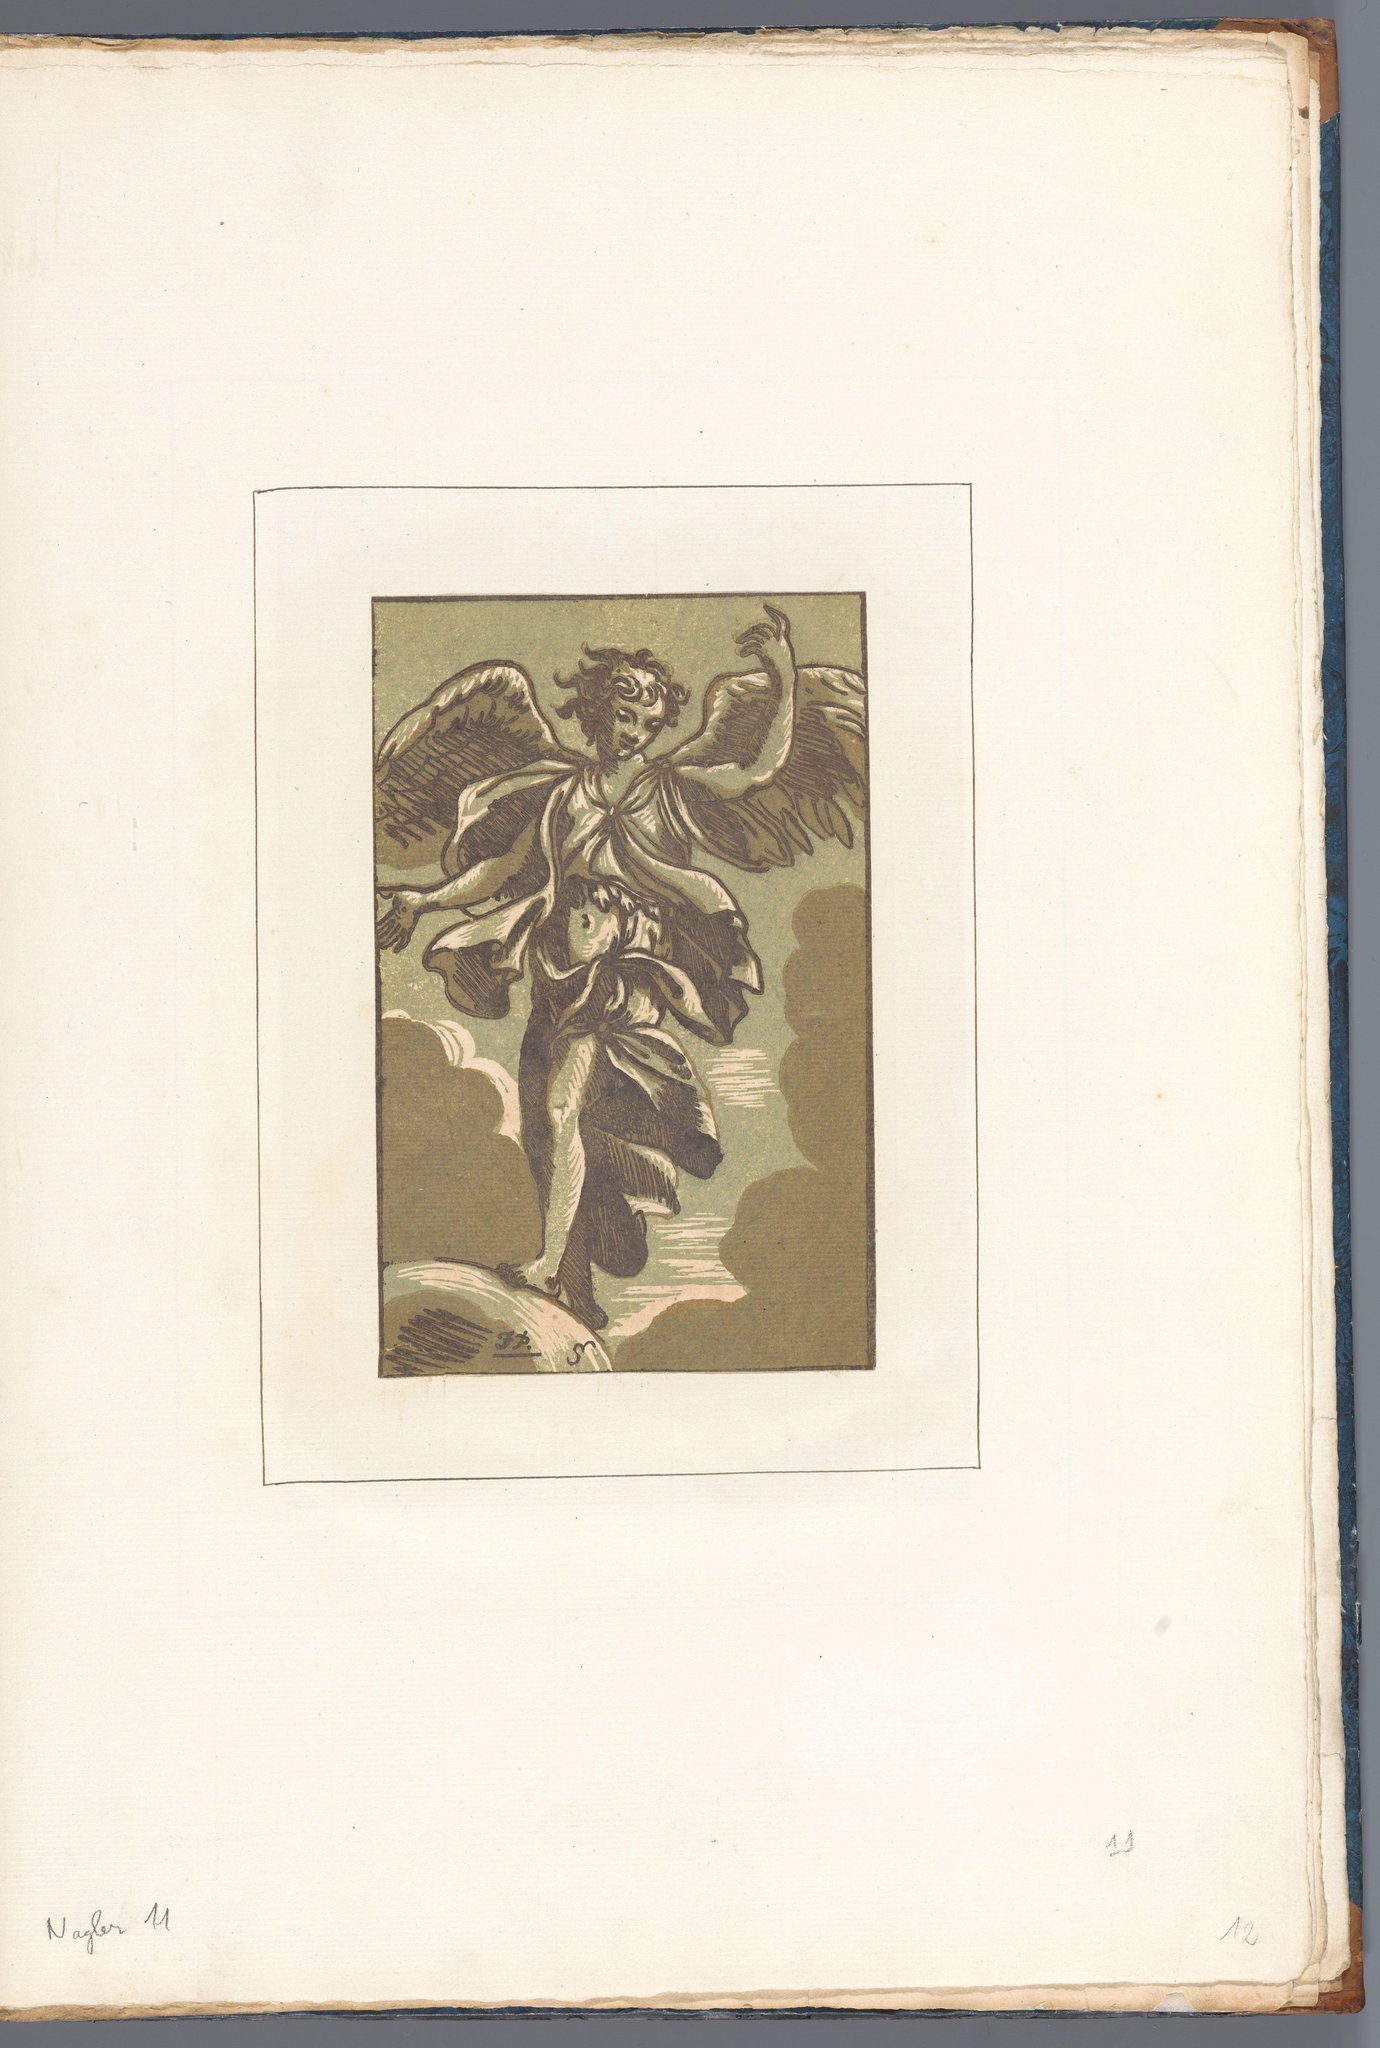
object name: print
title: Engel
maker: john b. skippe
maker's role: print maker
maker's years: 1741-1812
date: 1781-1783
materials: ink, paper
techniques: woodcut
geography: england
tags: angels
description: Engel staande in de wolken, met opgeheven linkerarm. Onderdeel van een album met 26 ingeplakte clair-obscur houtsneden naar Italiaanse kunstenaars uit de zestiende eeuw.